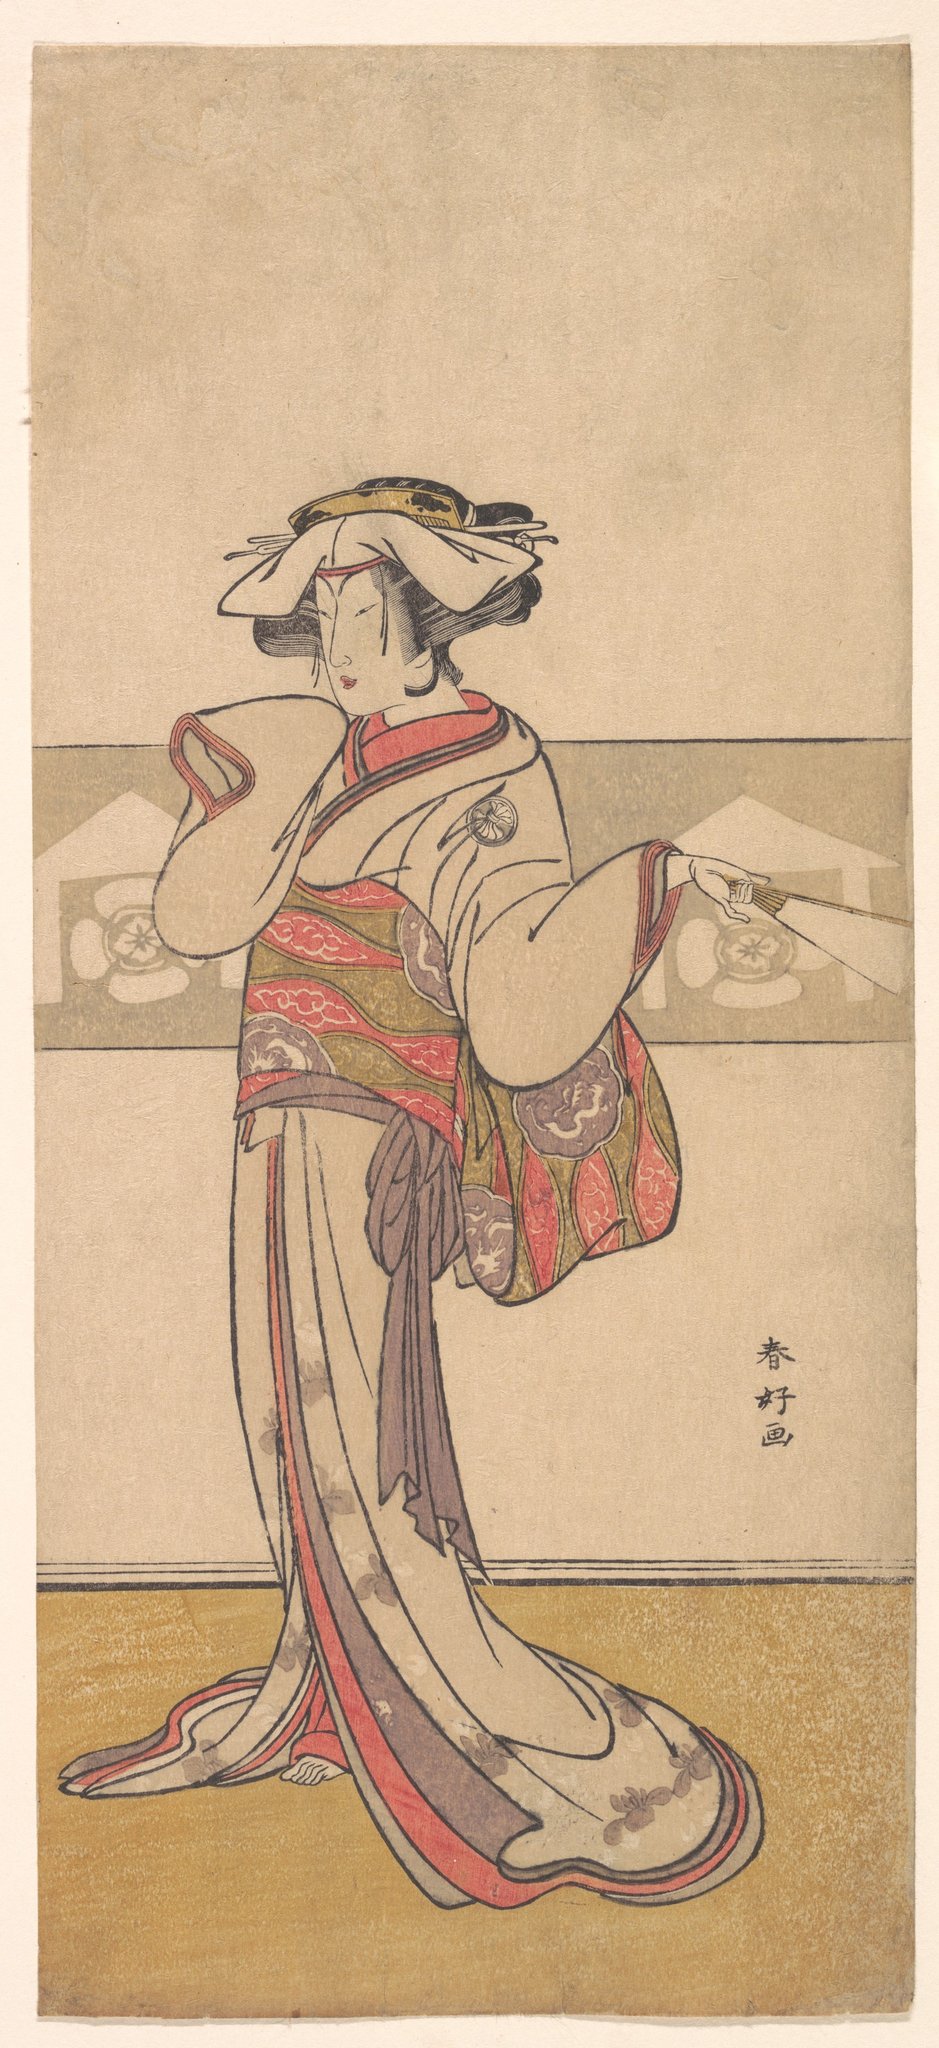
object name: print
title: Segawa Kikunojō III in the Role of Ōiso no Tora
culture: japanese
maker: katsukawa shunkō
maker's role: artist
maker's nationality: japanese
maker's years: 1743-1812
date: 1790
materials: ink, paper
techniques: woodblock print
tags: women,actors